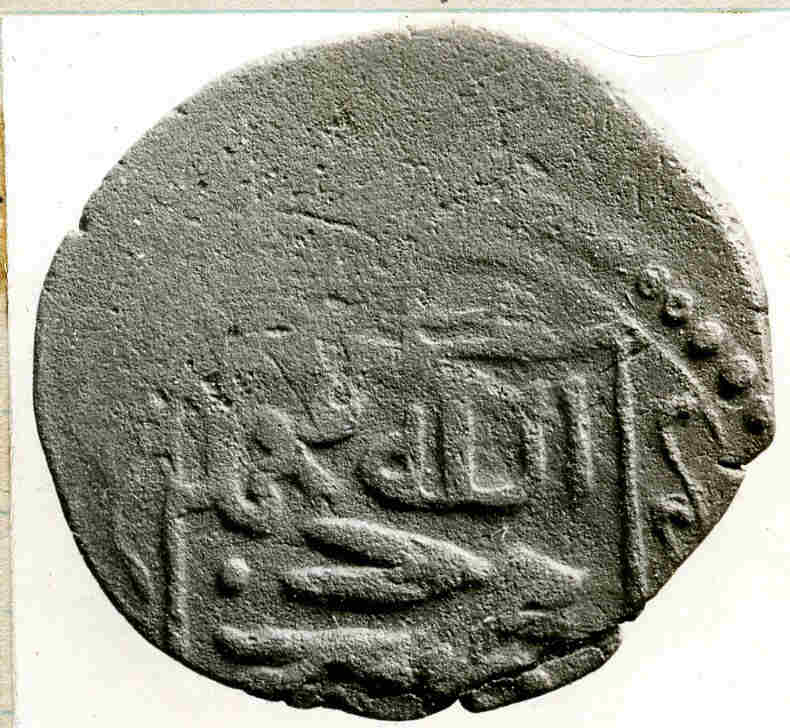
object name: coin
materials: copper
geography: iran